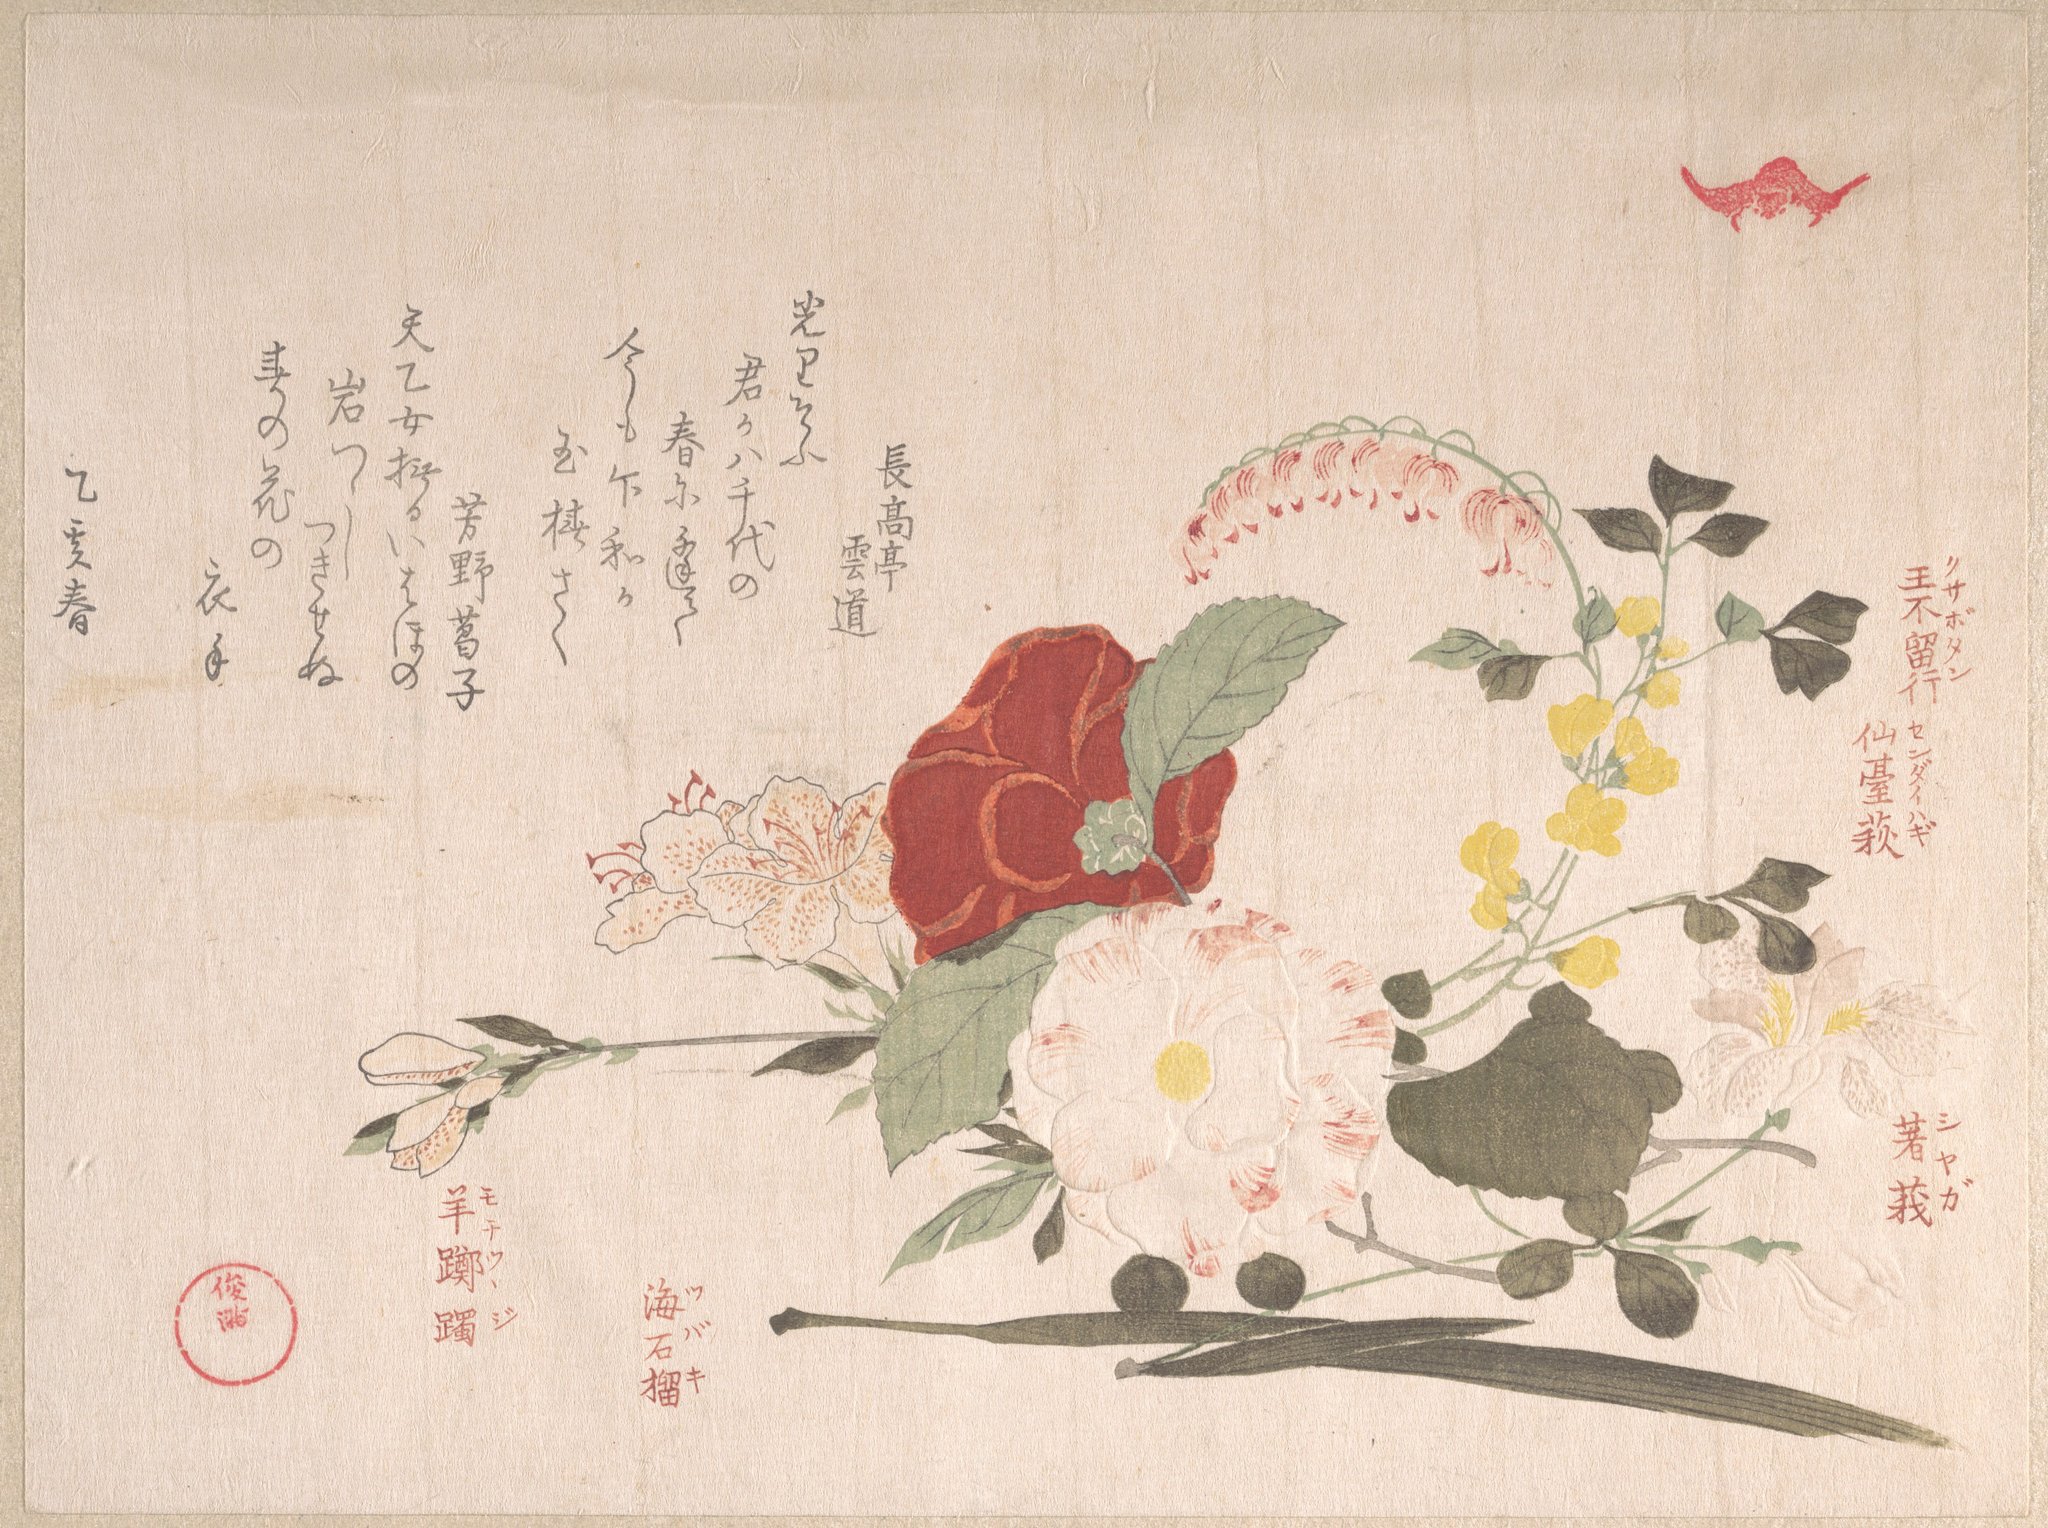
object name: print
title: Spring Rain Collection (Harusame shū), vol. 2: Cut Flowers: Clematis, Bush Clover, Iris, Camellia, and Azalea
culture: japanese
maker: kubo shunman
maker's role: artist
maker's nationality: japanese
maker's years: 1757-1820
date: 1815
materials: ink, paper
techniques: surimono, woodblock print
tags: flowers,leaves